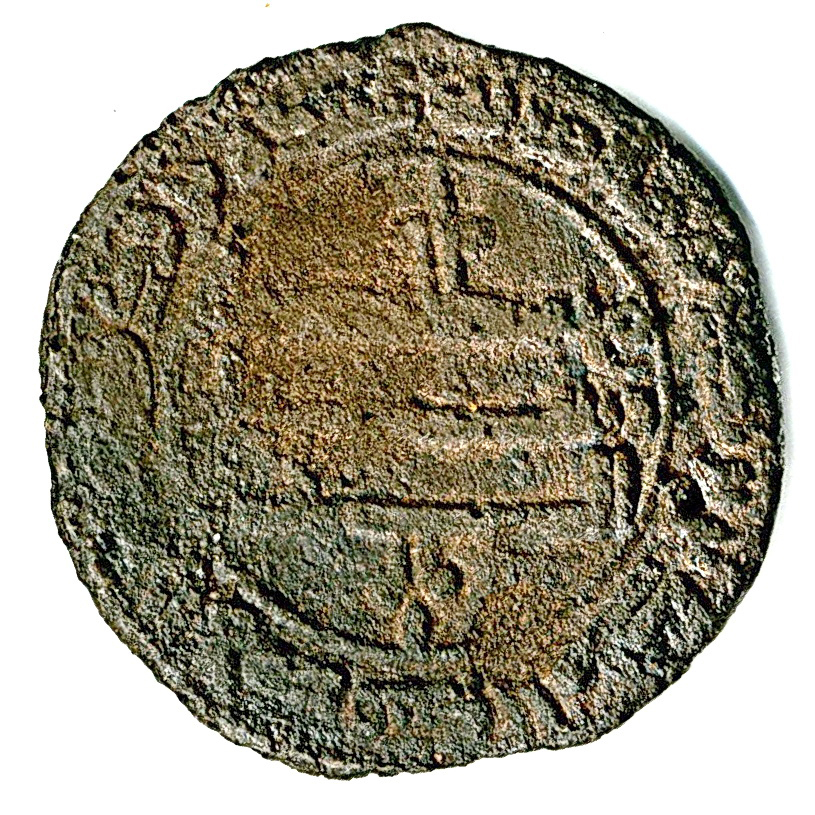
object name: coin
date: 401-1400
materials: copper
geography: iran